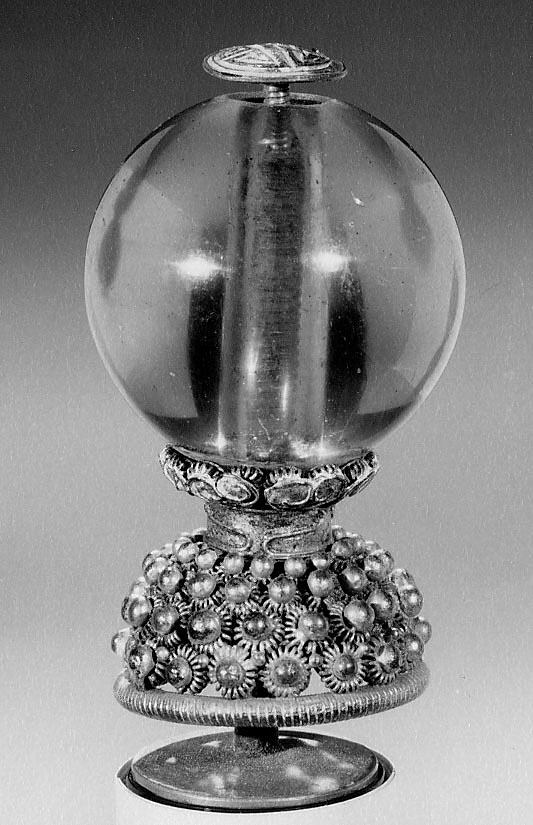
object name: hat finial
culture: chinese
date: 1901-1933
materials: glass